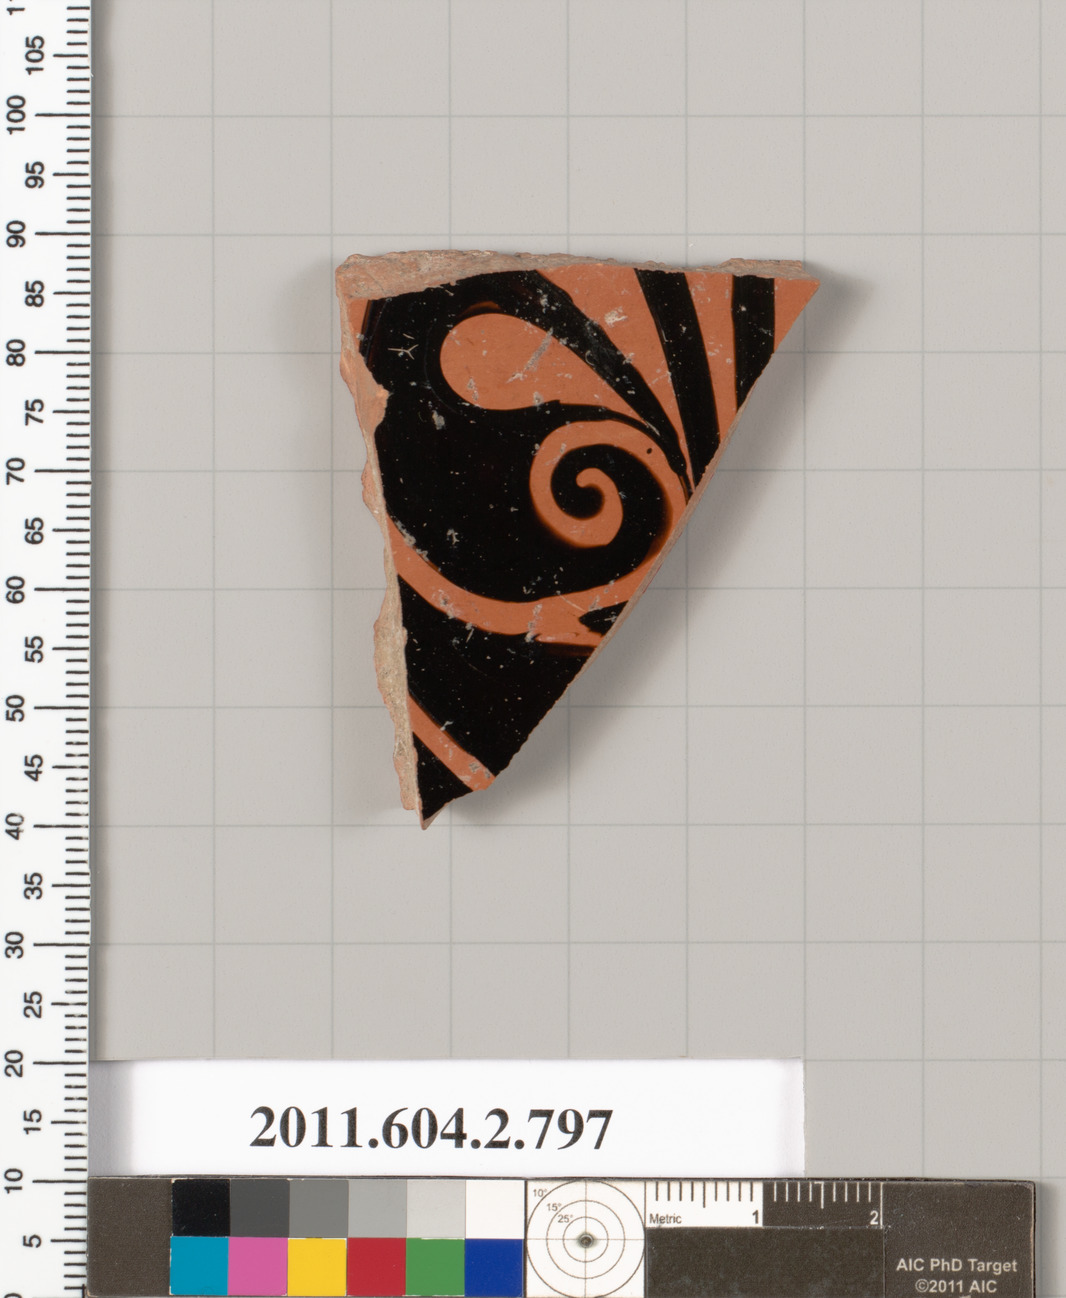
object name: calyx krater fragment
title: Terracotta fragment of a calyx-krater (bowl for mixing wine and water)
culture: greek, attic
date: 470-450 BCE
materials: terracotta